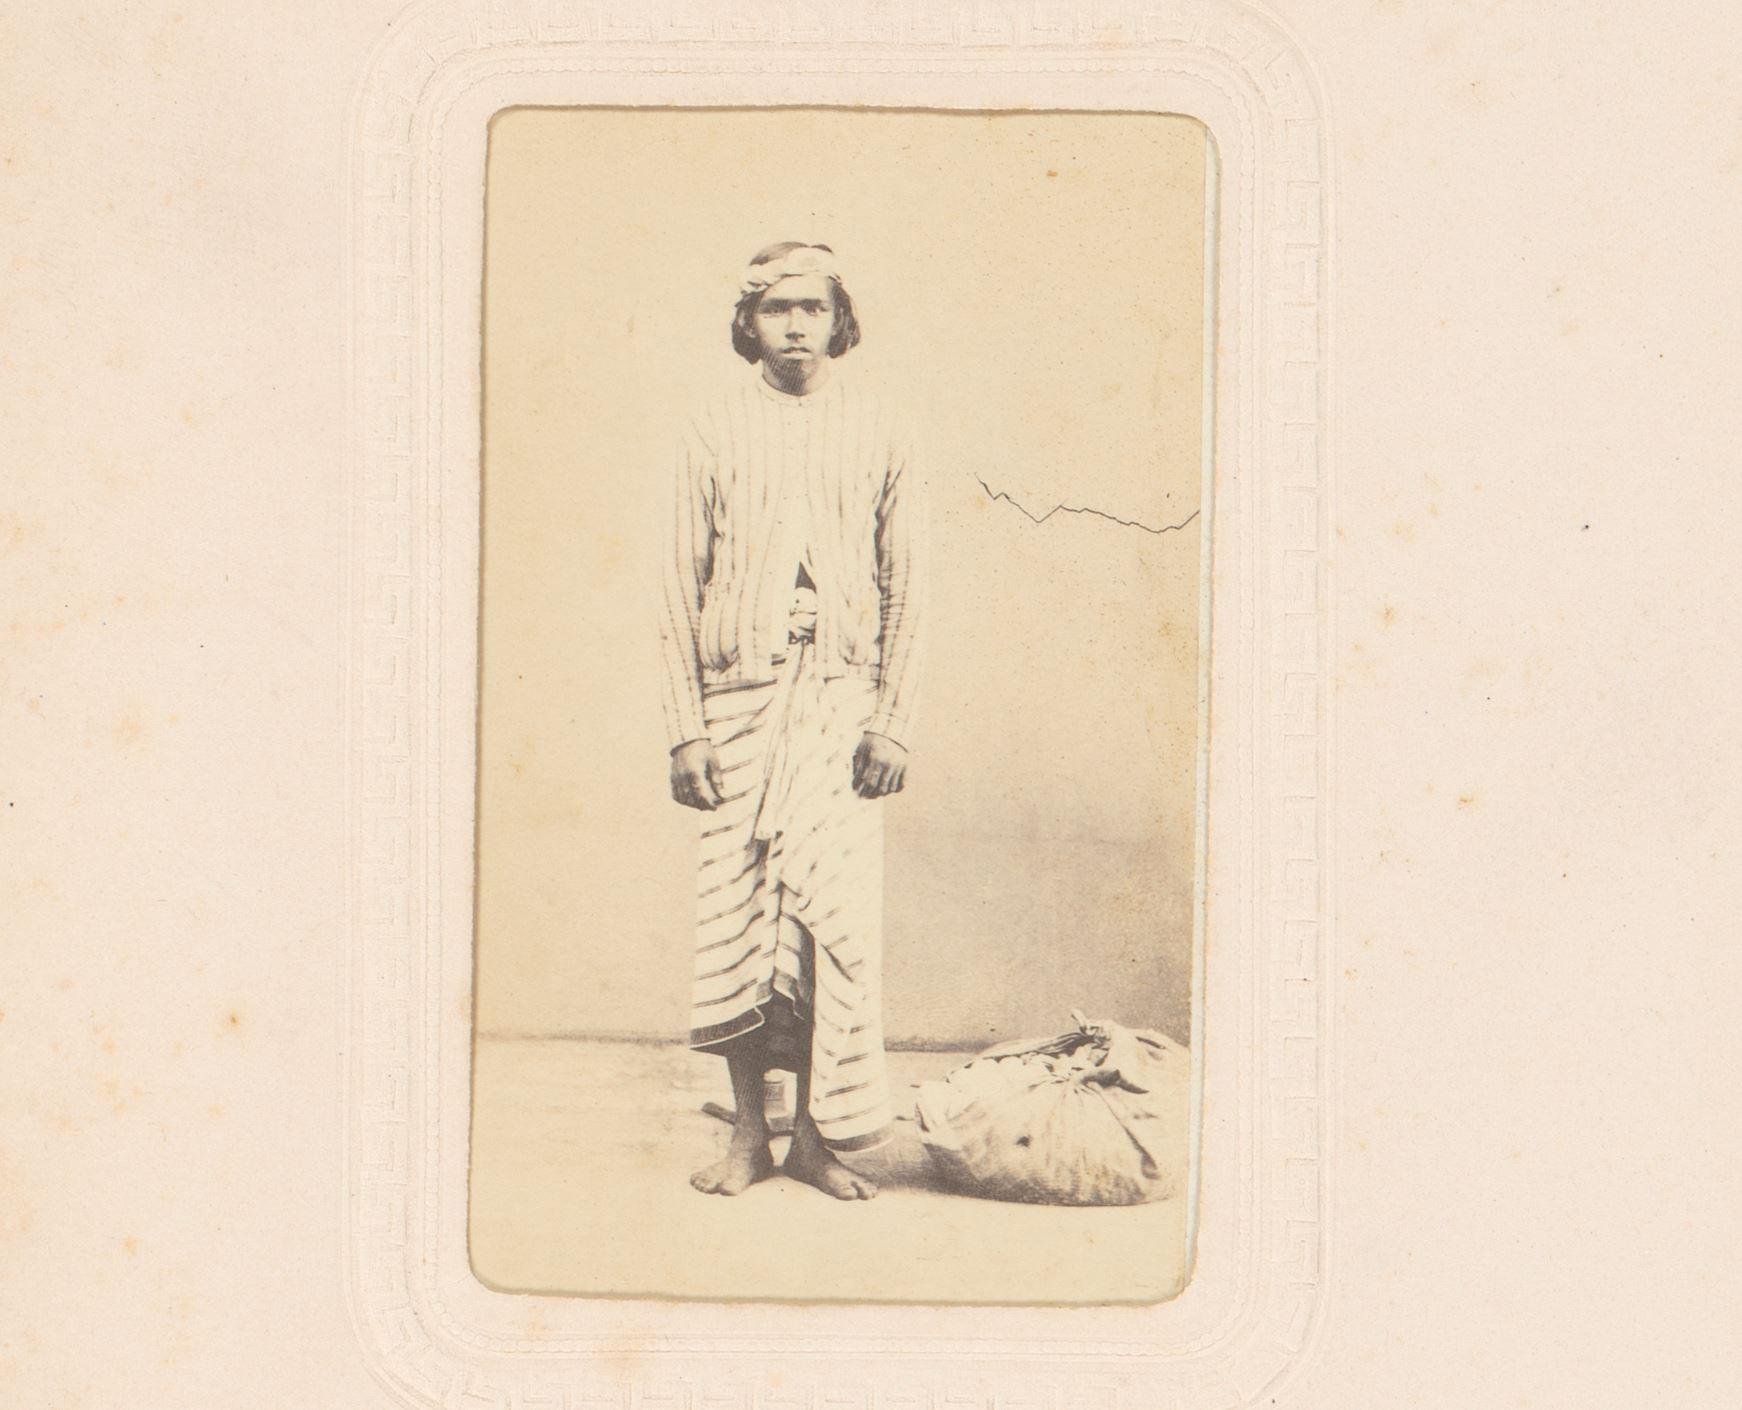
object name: album leaf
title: Portret van een Indiase jongen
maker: Anonymous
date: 1850-1880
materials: cardboard, photographic support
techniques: albumen print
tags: historical persons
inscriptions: number: ‘13’